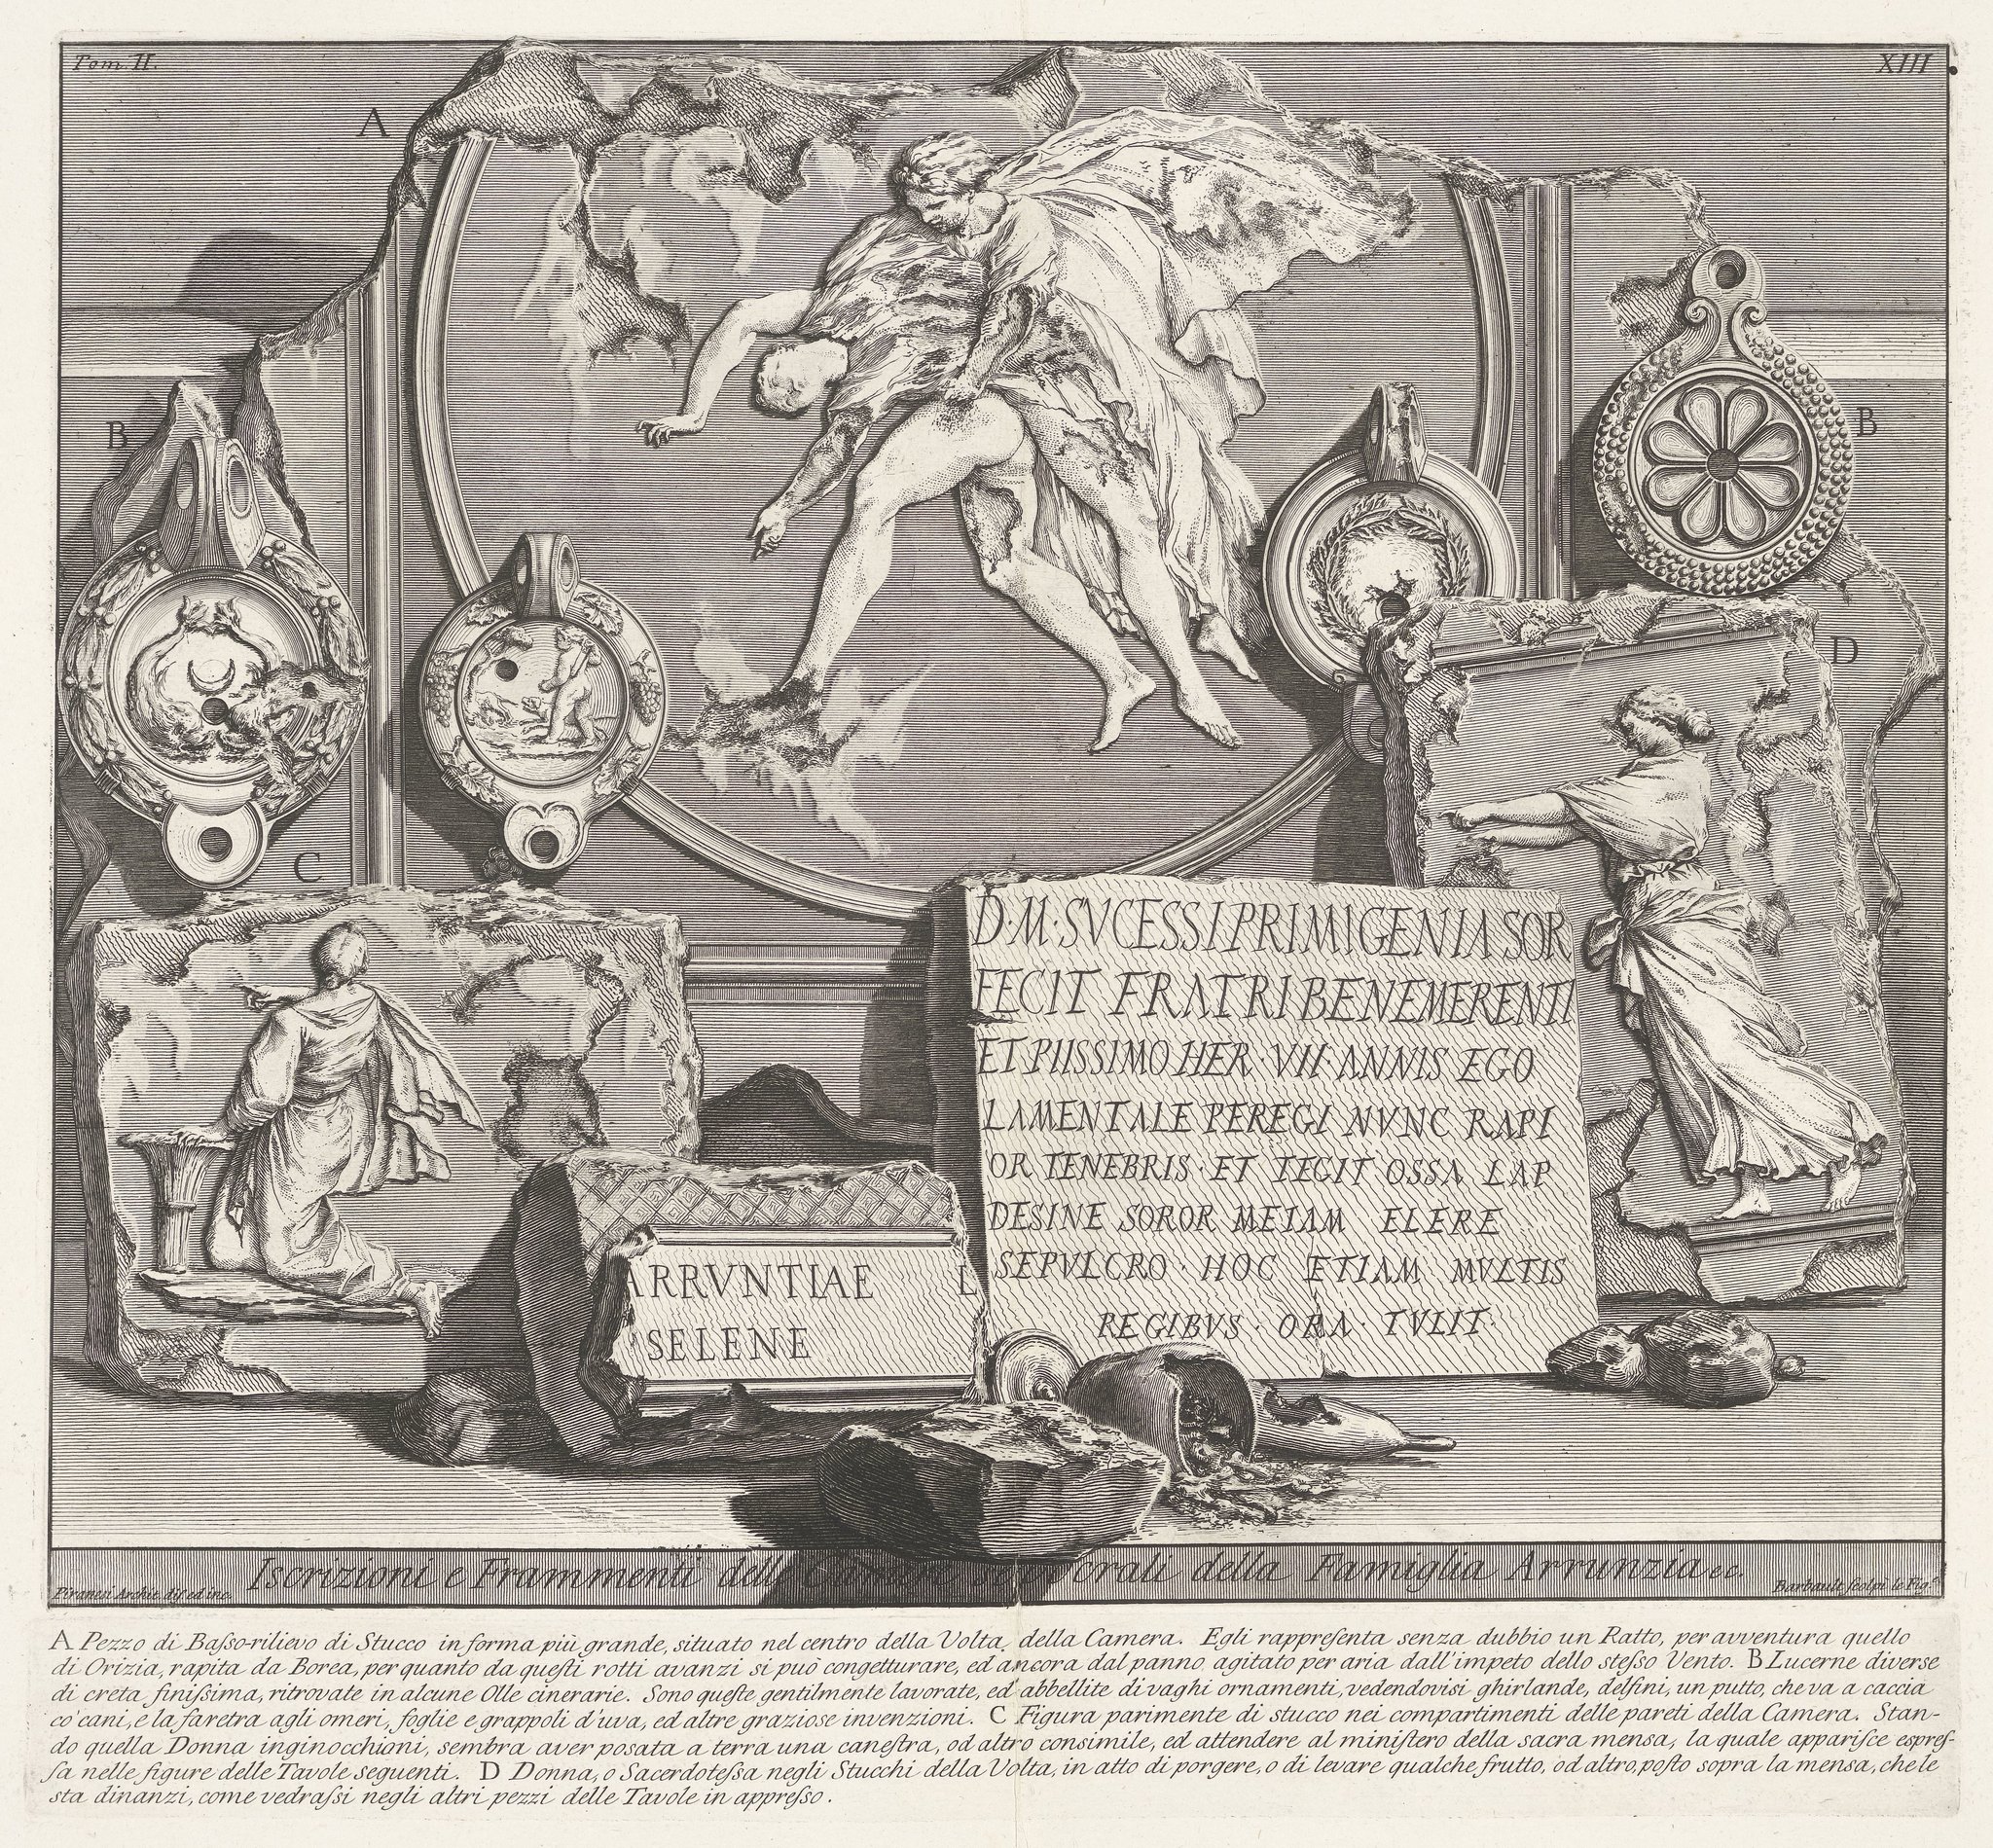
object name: print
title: Inscripties en fragmenten uit graftombe van de Arruntius familie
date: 1756-1757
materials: paper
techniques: etching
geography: rome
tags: inscription, oil-lamp, piece of sculpture, reproduction of a piece of sculpture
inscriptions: collector's mark: Lugt 2228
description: Deze prent maakt deel uit van de serie 'Le Antichità Romane'. Piranesi deed meer dan acht jaar voorstudie voor deze 250 platen tellende serie die in vier volumes werd uitgegeven. Hij produceerde de prenten tussen ca. 1756 en 1757. De serie bevat ook prenten door of naar andere prentmakers, onder wie Francesco Bianchini en Girolamo Rossi.